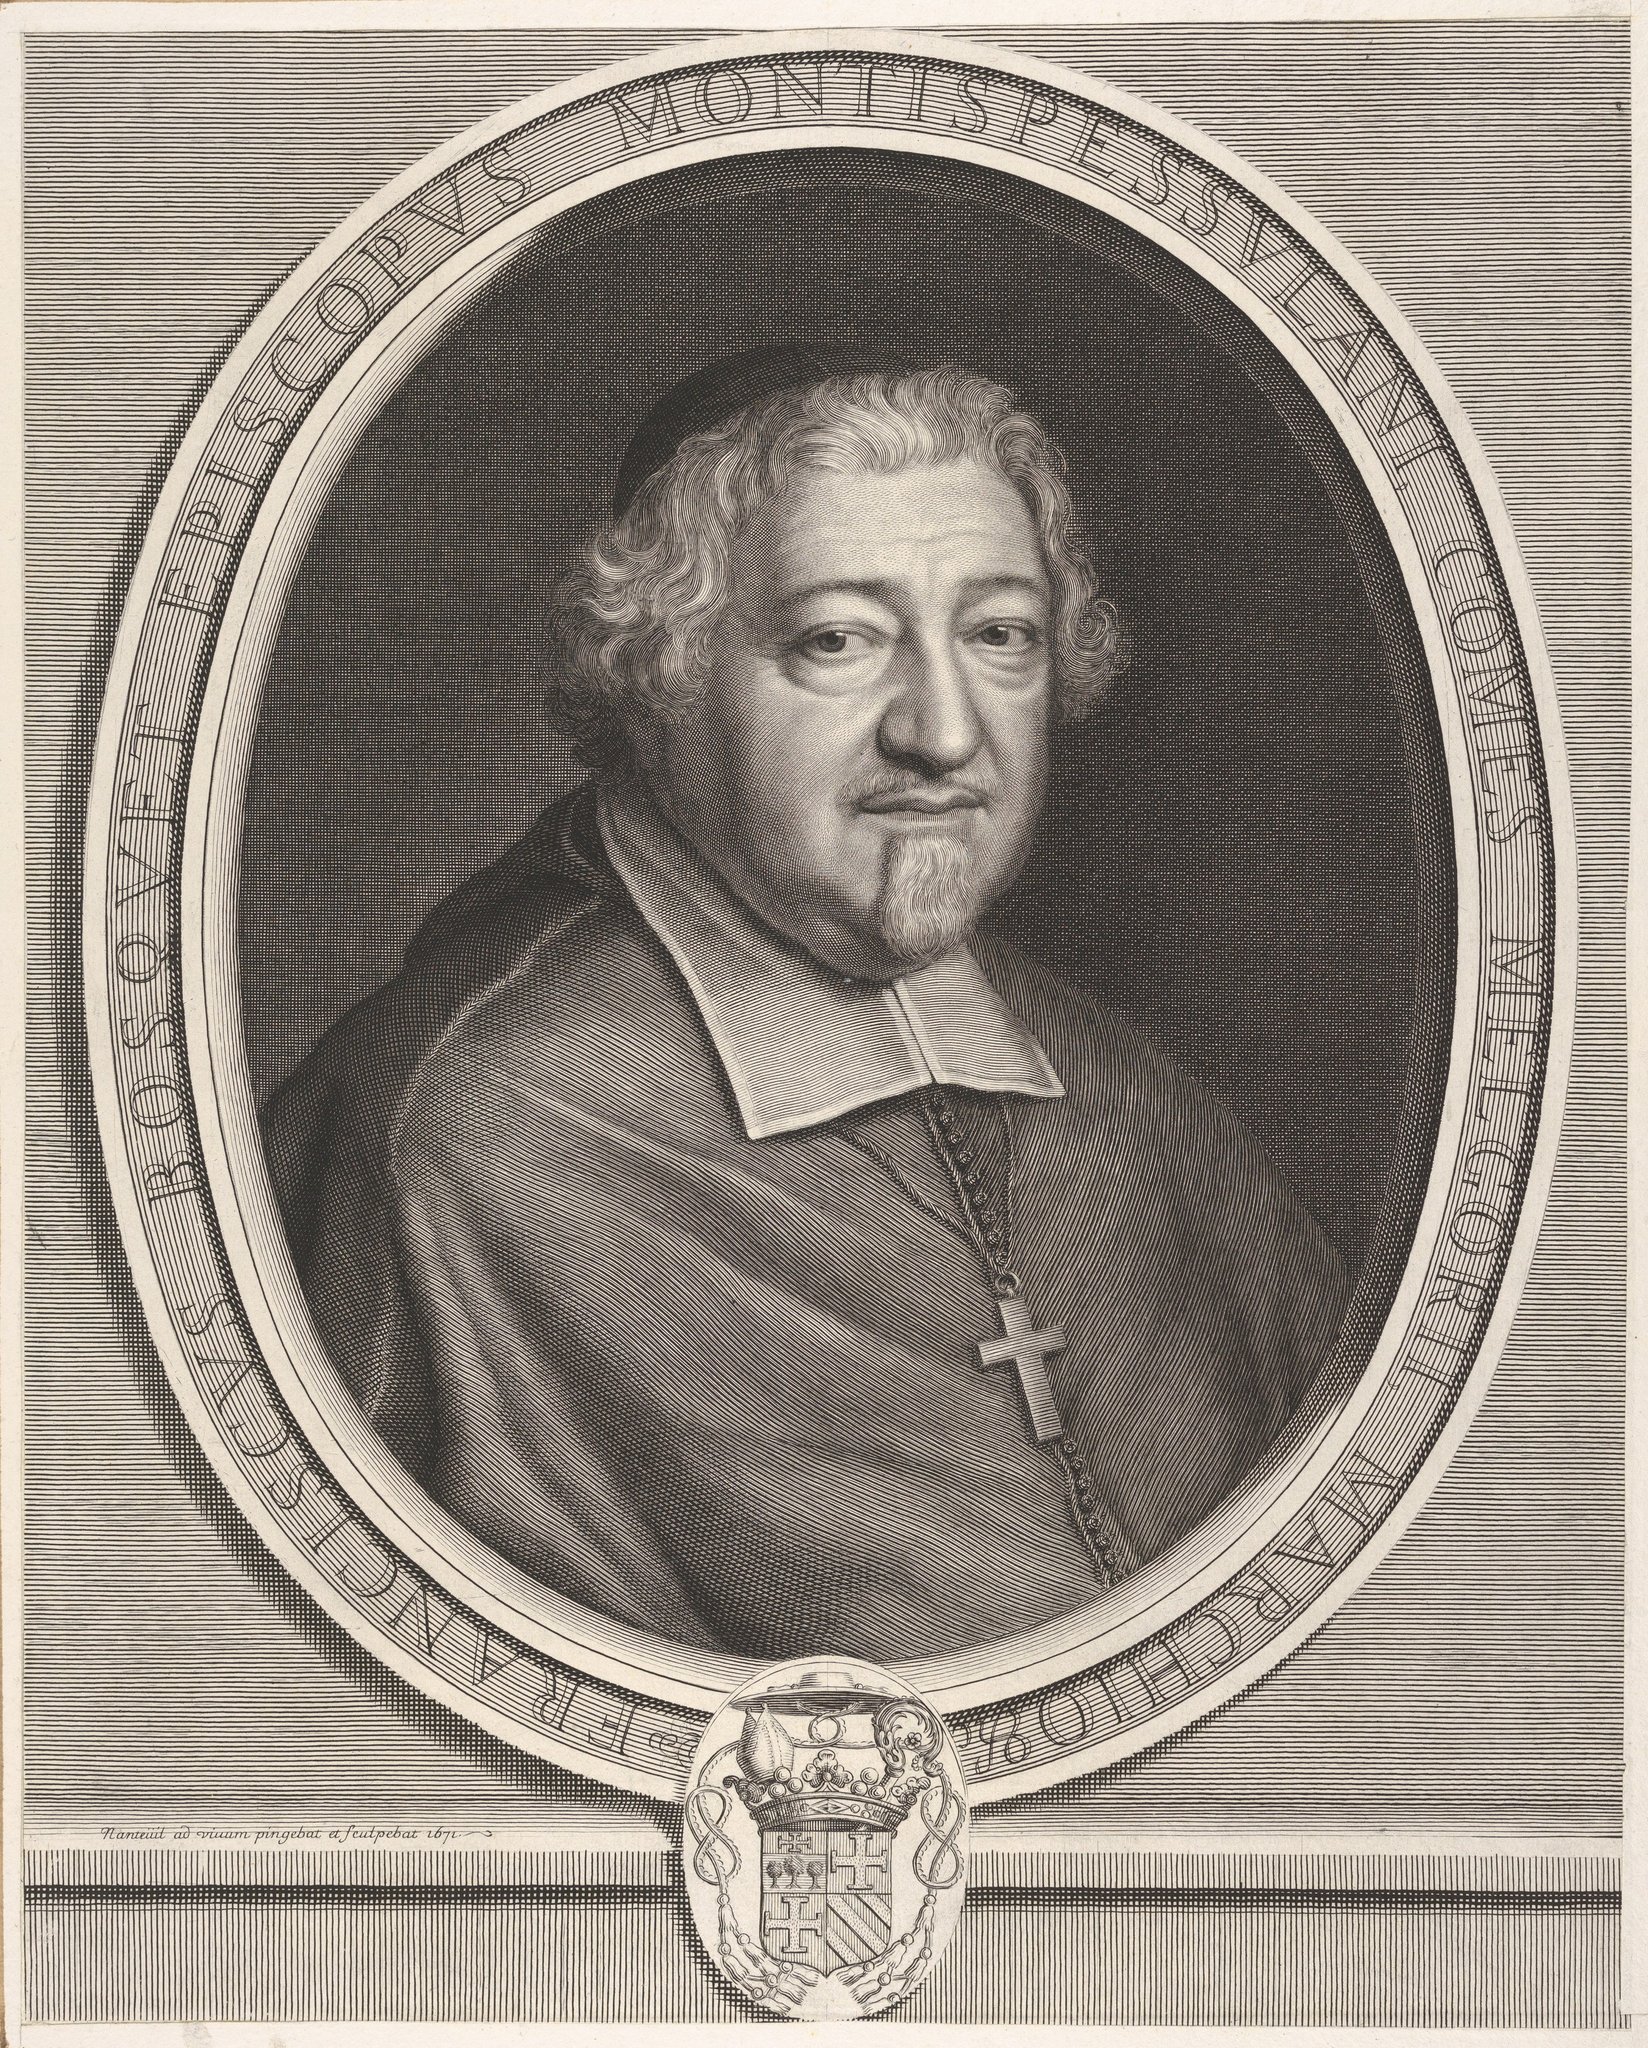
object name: print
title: François Bosquet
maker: robert nanteuil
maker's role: artist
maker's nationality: french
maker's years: 1623-1678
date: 1671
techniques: engraving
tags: men,portraits,cross,coat of arms